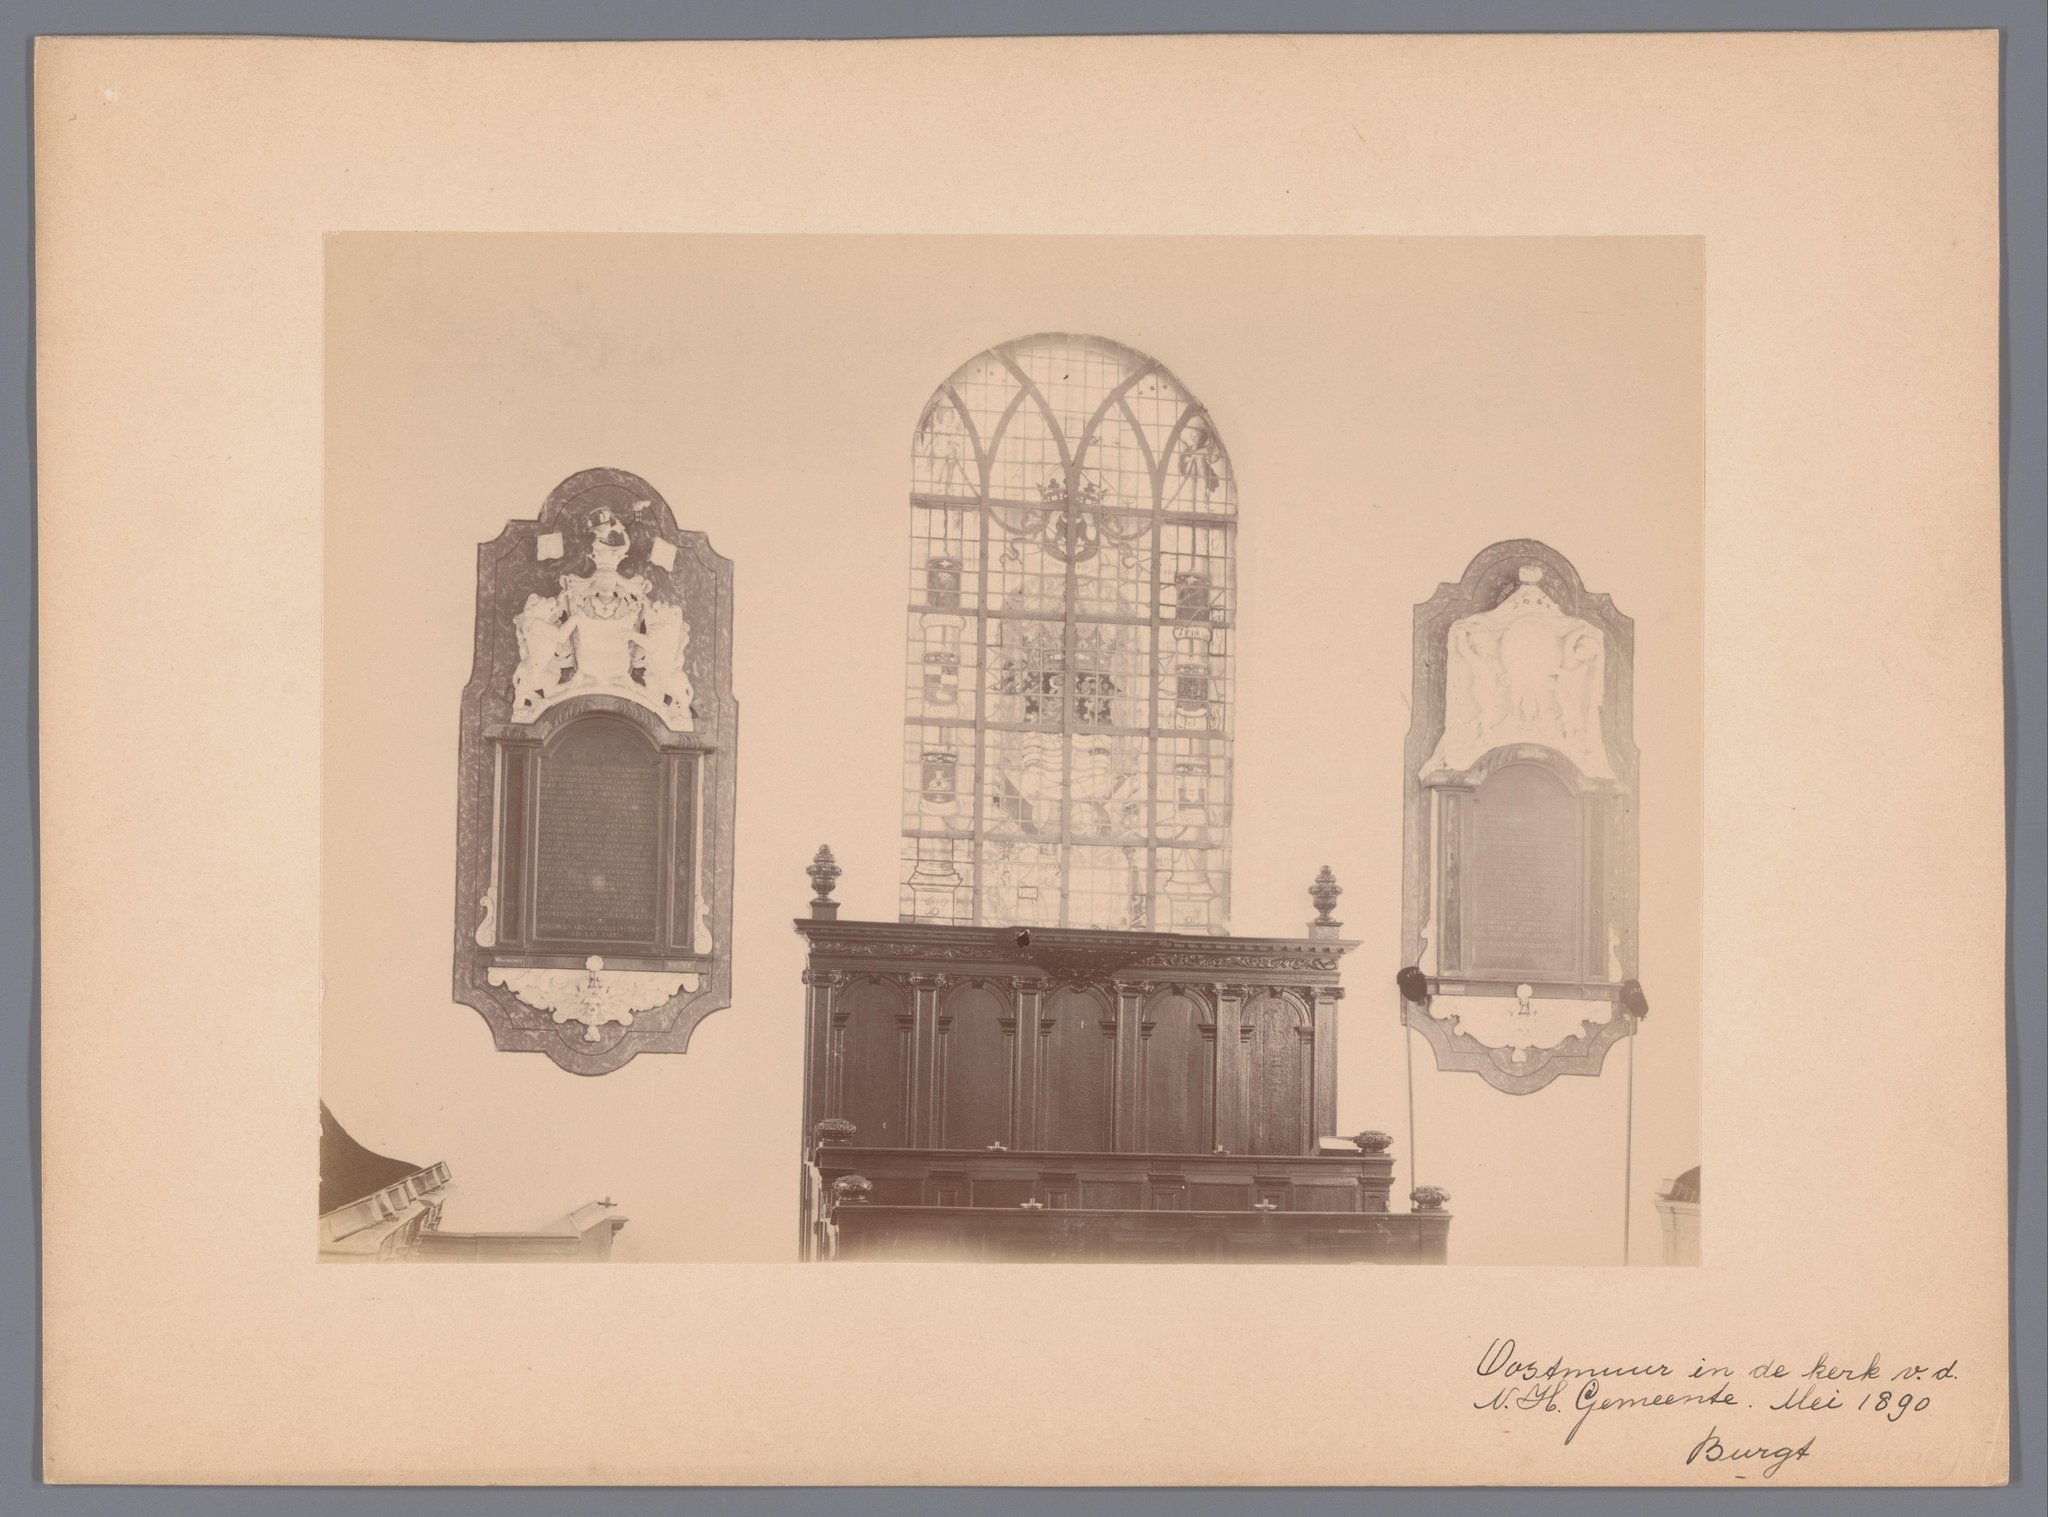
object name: photograph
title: Oostmuur in de Hervormde Kerk te Burgh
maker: anoniem (monumentenzorg)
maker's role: fotograaf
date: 1890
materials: cardboard, photographic support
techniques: albumen print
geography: burgh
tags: church-window, e.g. rose-window, interior of church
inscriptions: annotation: ‘Oostmuur in de kerk v.d. N.H. gemeente. Mei 1890/ Burgt’, annotation: ‘Oostmuur in de Kerk v/d N.H. gemeente Brugh (schouwen) Zeeland/ Mei 1890’